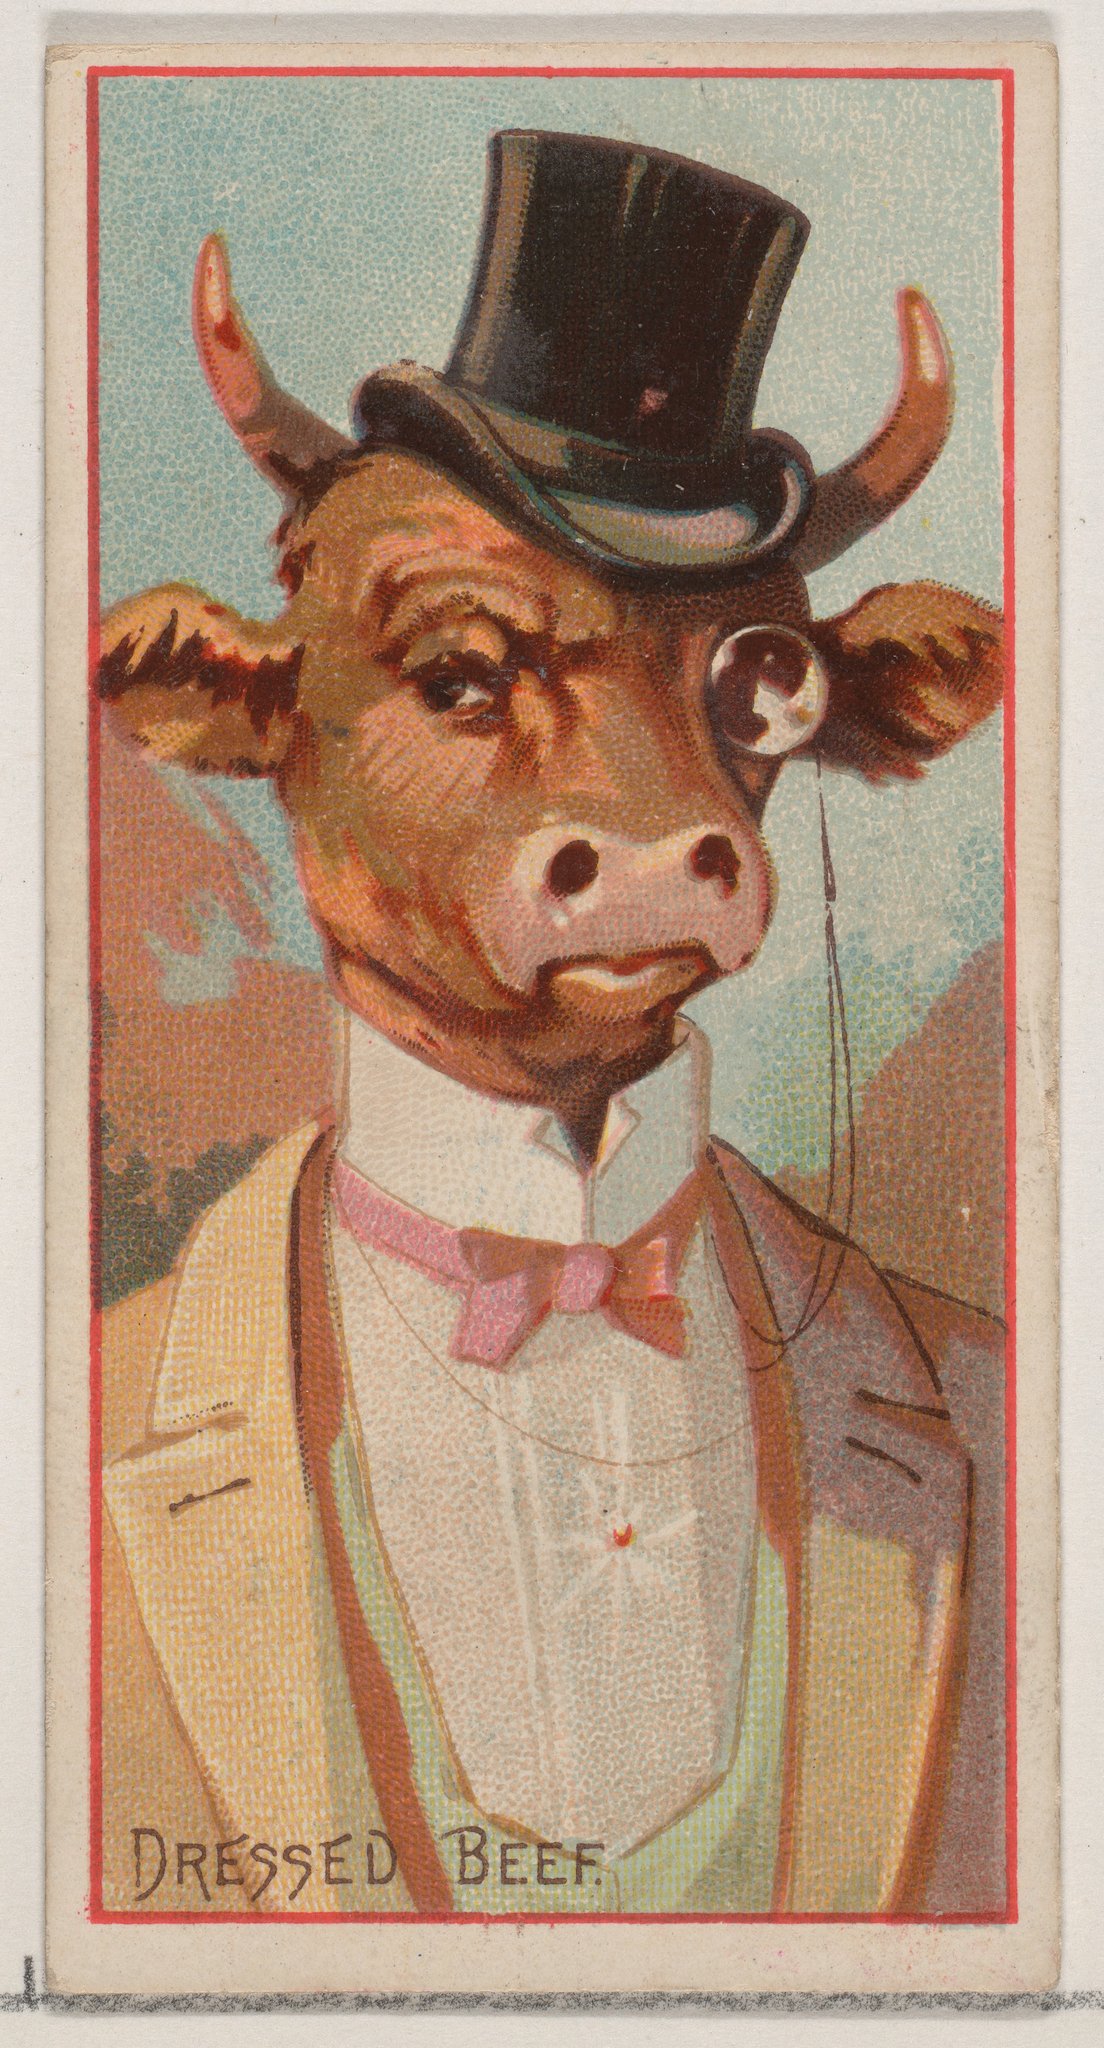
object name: print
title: Dressed Beef, from the Jokes series (N87) for Duke brand cigarettes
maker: w. duke, sons & co.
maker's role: publisher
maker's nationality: american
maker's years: 1870-1920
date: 1890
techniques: color lithograph